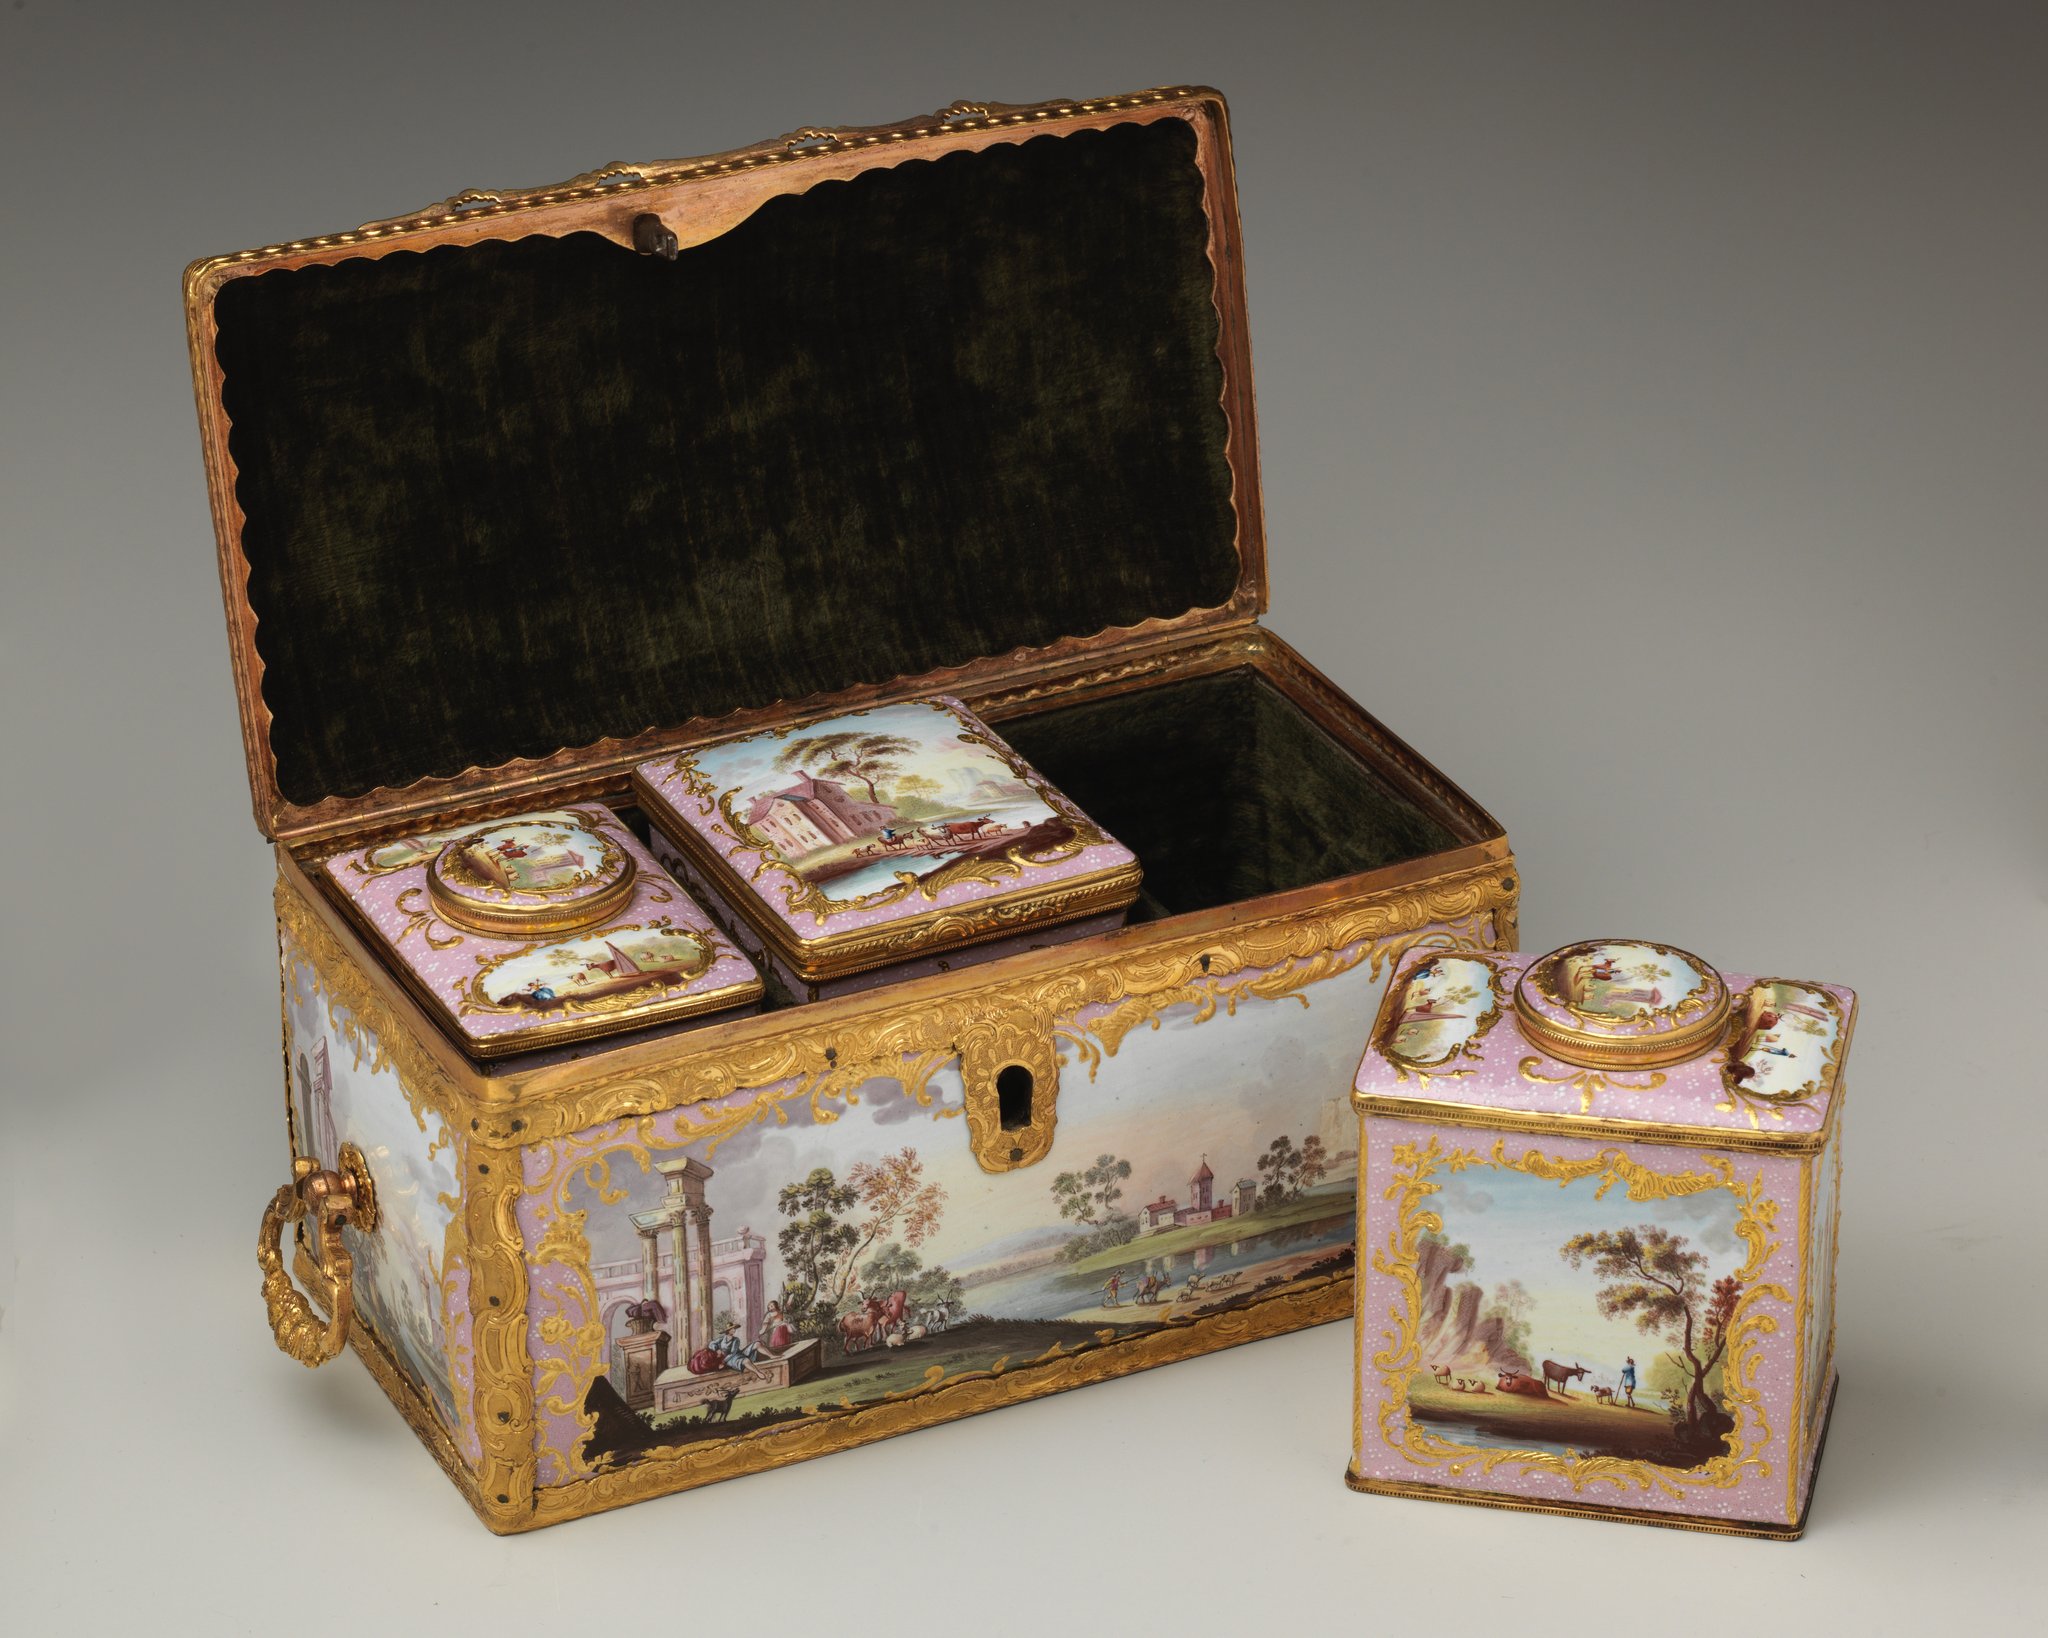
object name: tea caddy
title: Tea caddy (part of a set)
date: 1765-1770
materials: copper, enamel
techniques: painting, polychrome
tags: animals,landscapes,pastoral